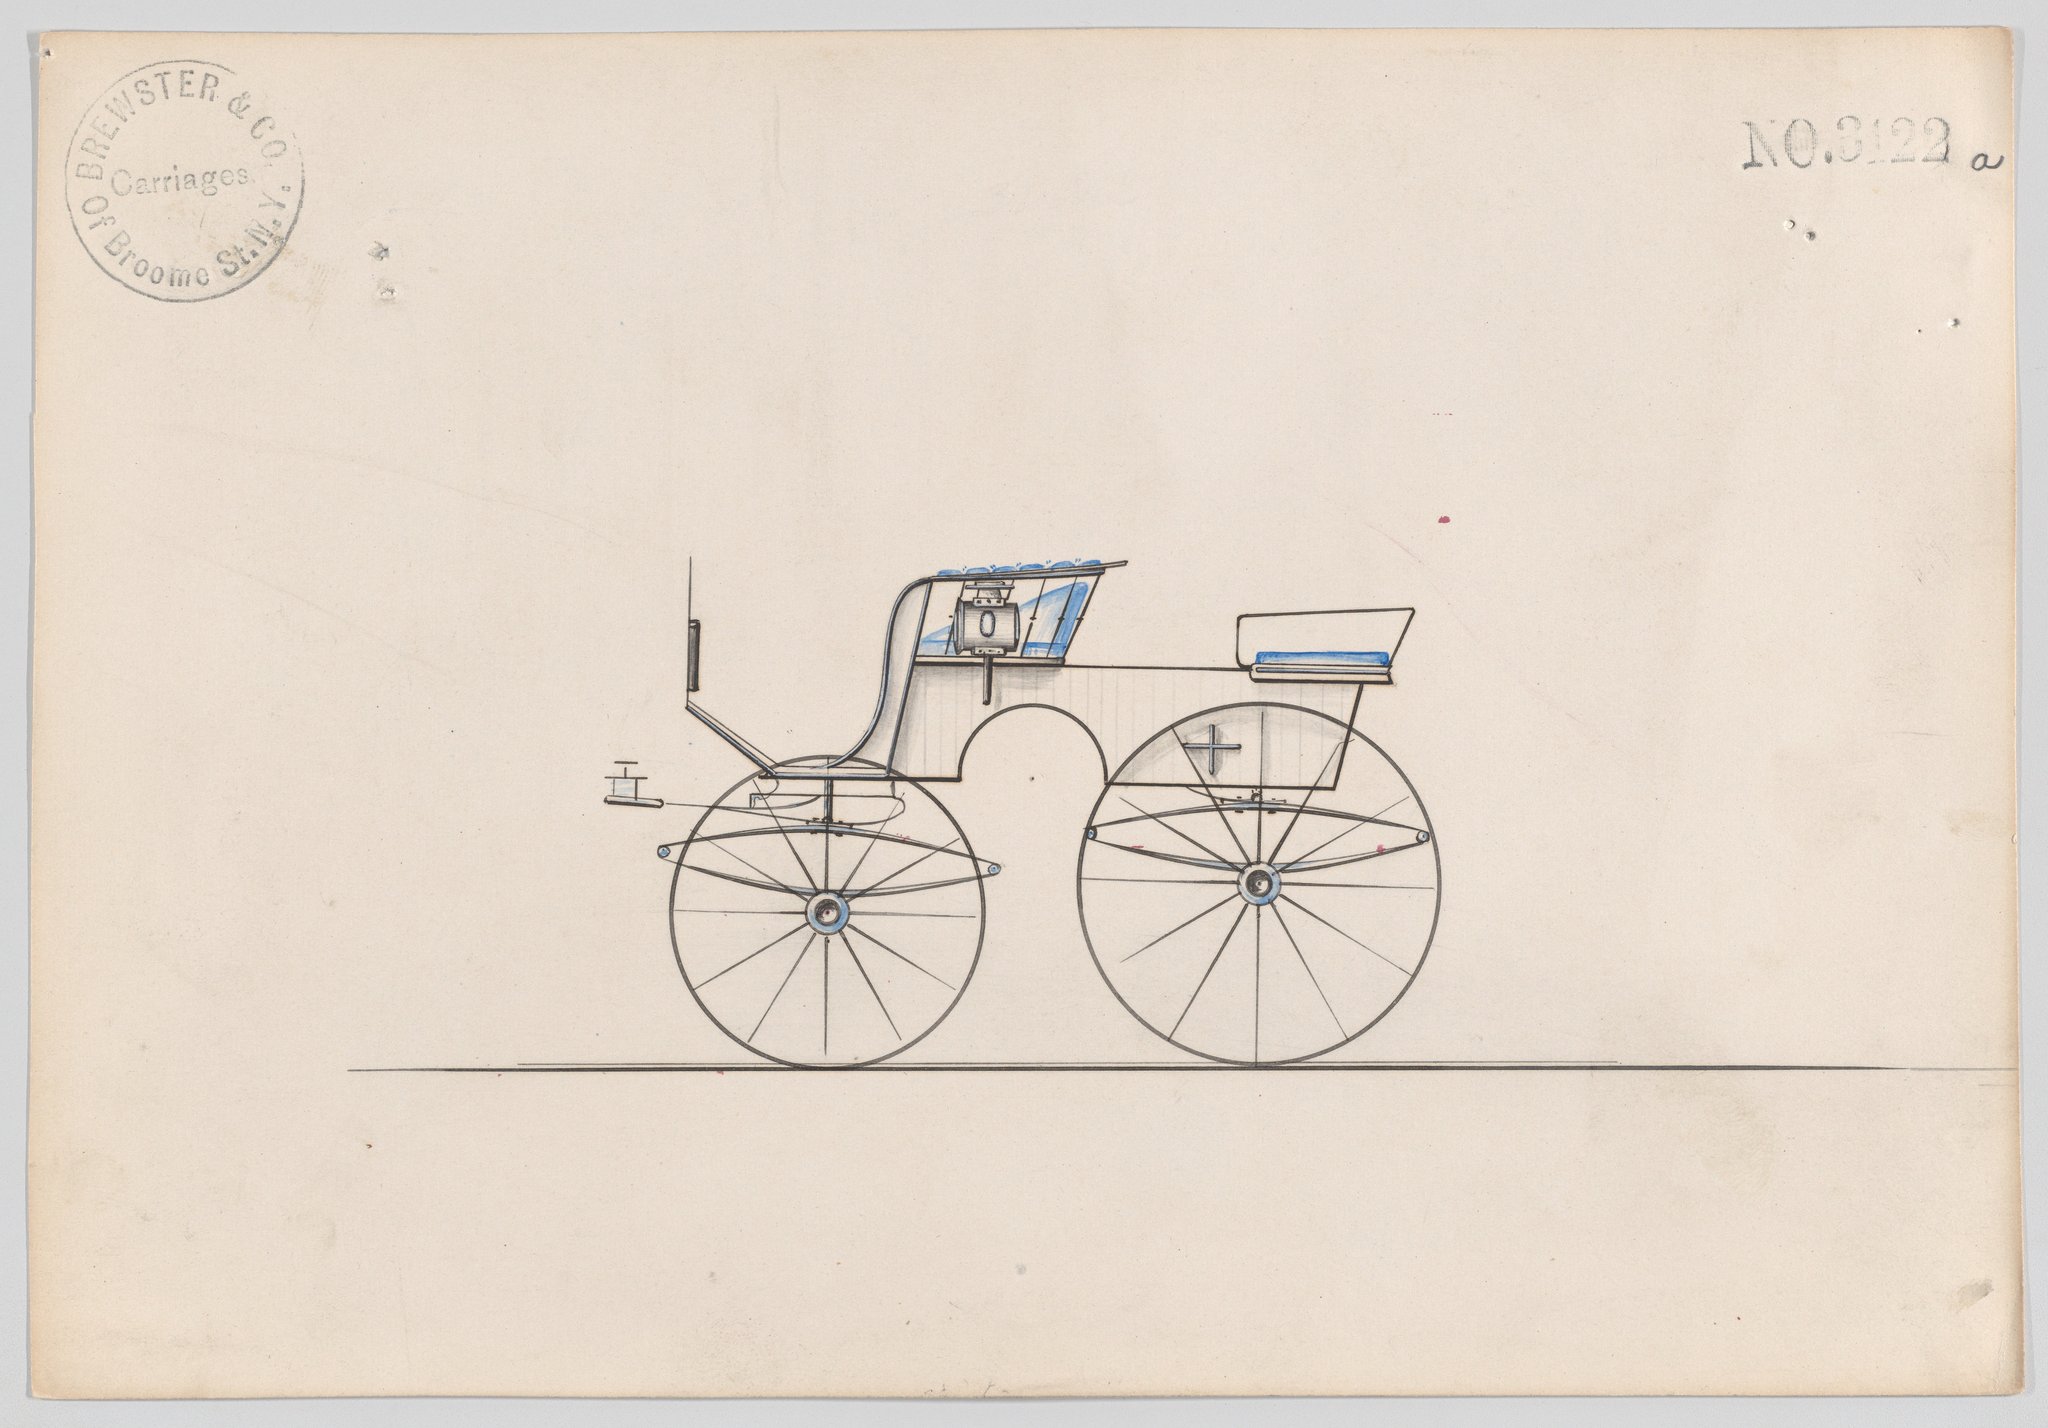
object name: drawing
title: Design for T-Cart, no. 3122a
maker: brewster & co.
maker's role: manufacturer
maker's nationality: american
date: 1875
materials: gouache, ink, watercolor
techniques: pen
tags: carriages